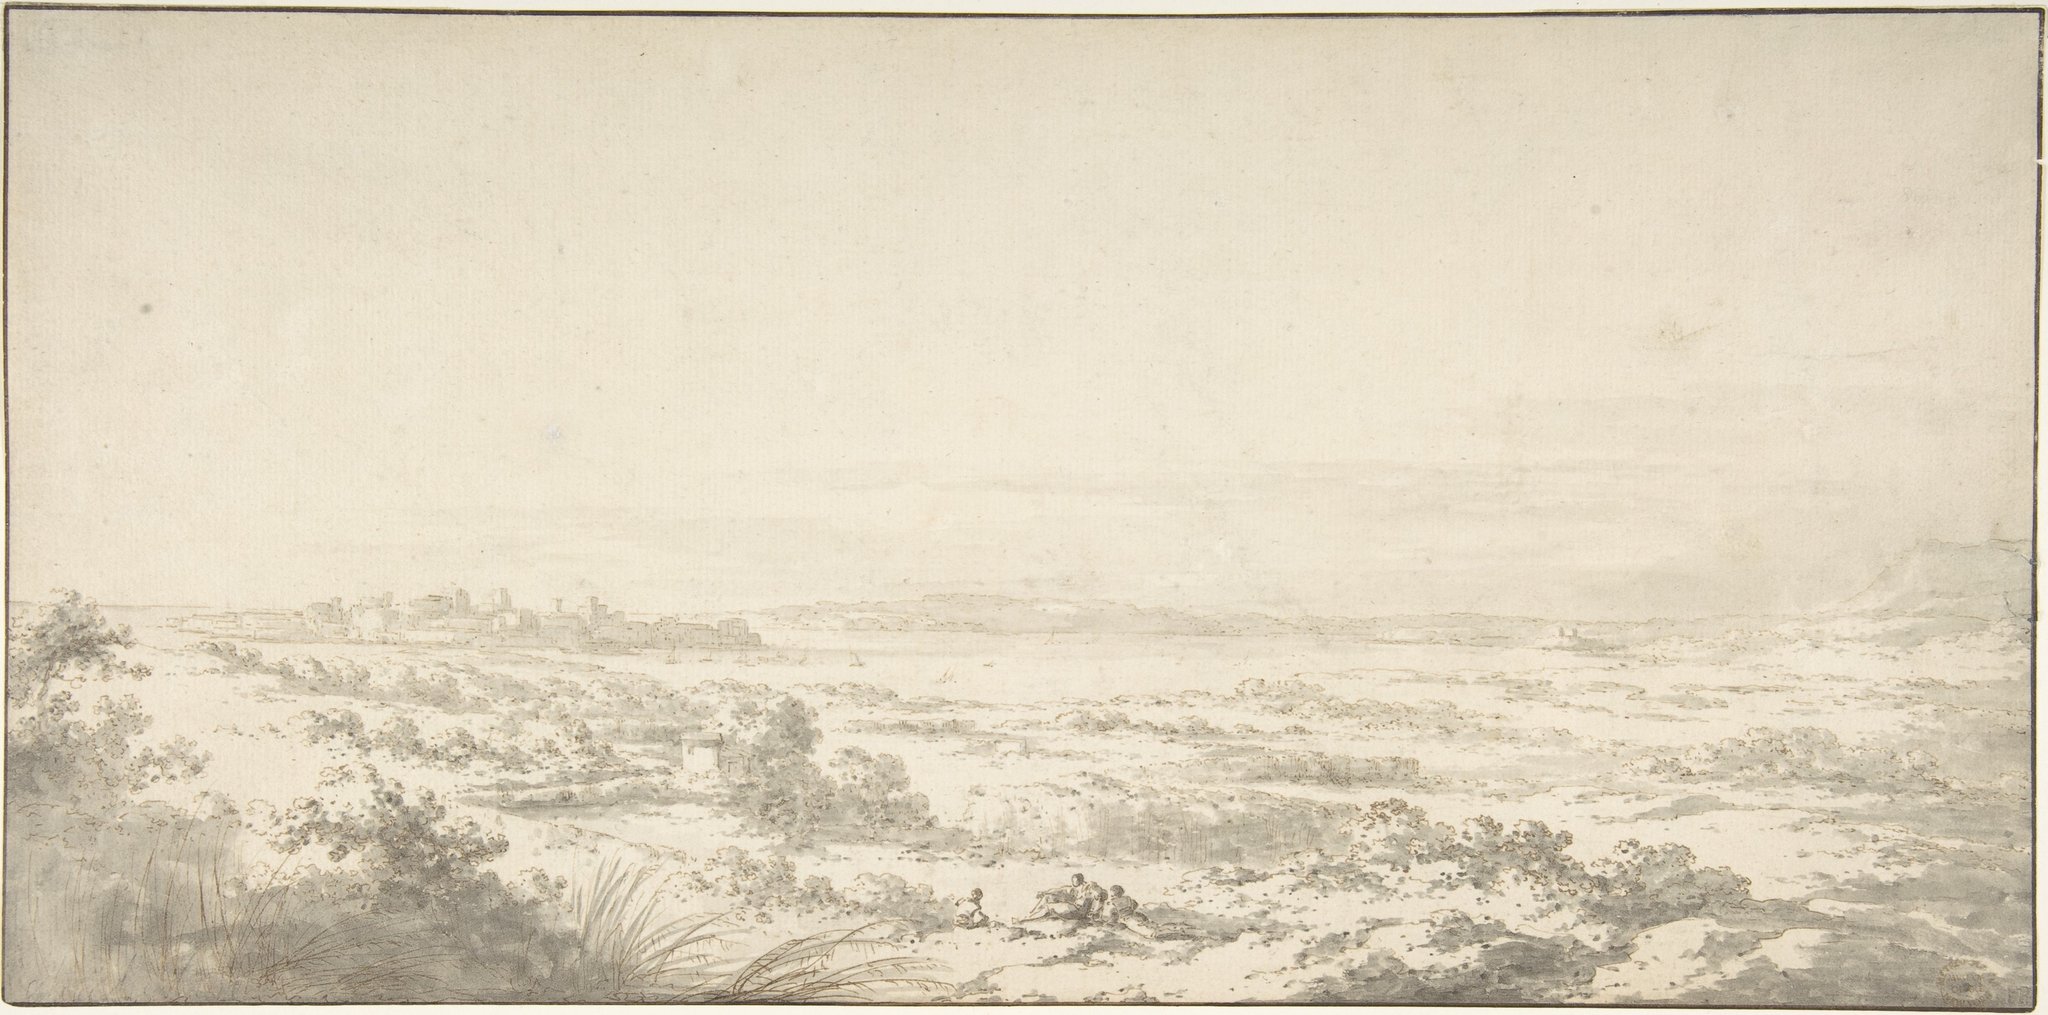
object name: drawing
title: Distant View of Syracuse and its Harbor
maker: claude louis châtelet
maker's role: artist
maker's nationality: french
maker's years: 1753-1794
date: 1767-1800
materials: graphite, ink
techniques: pen, wash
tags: landscapes